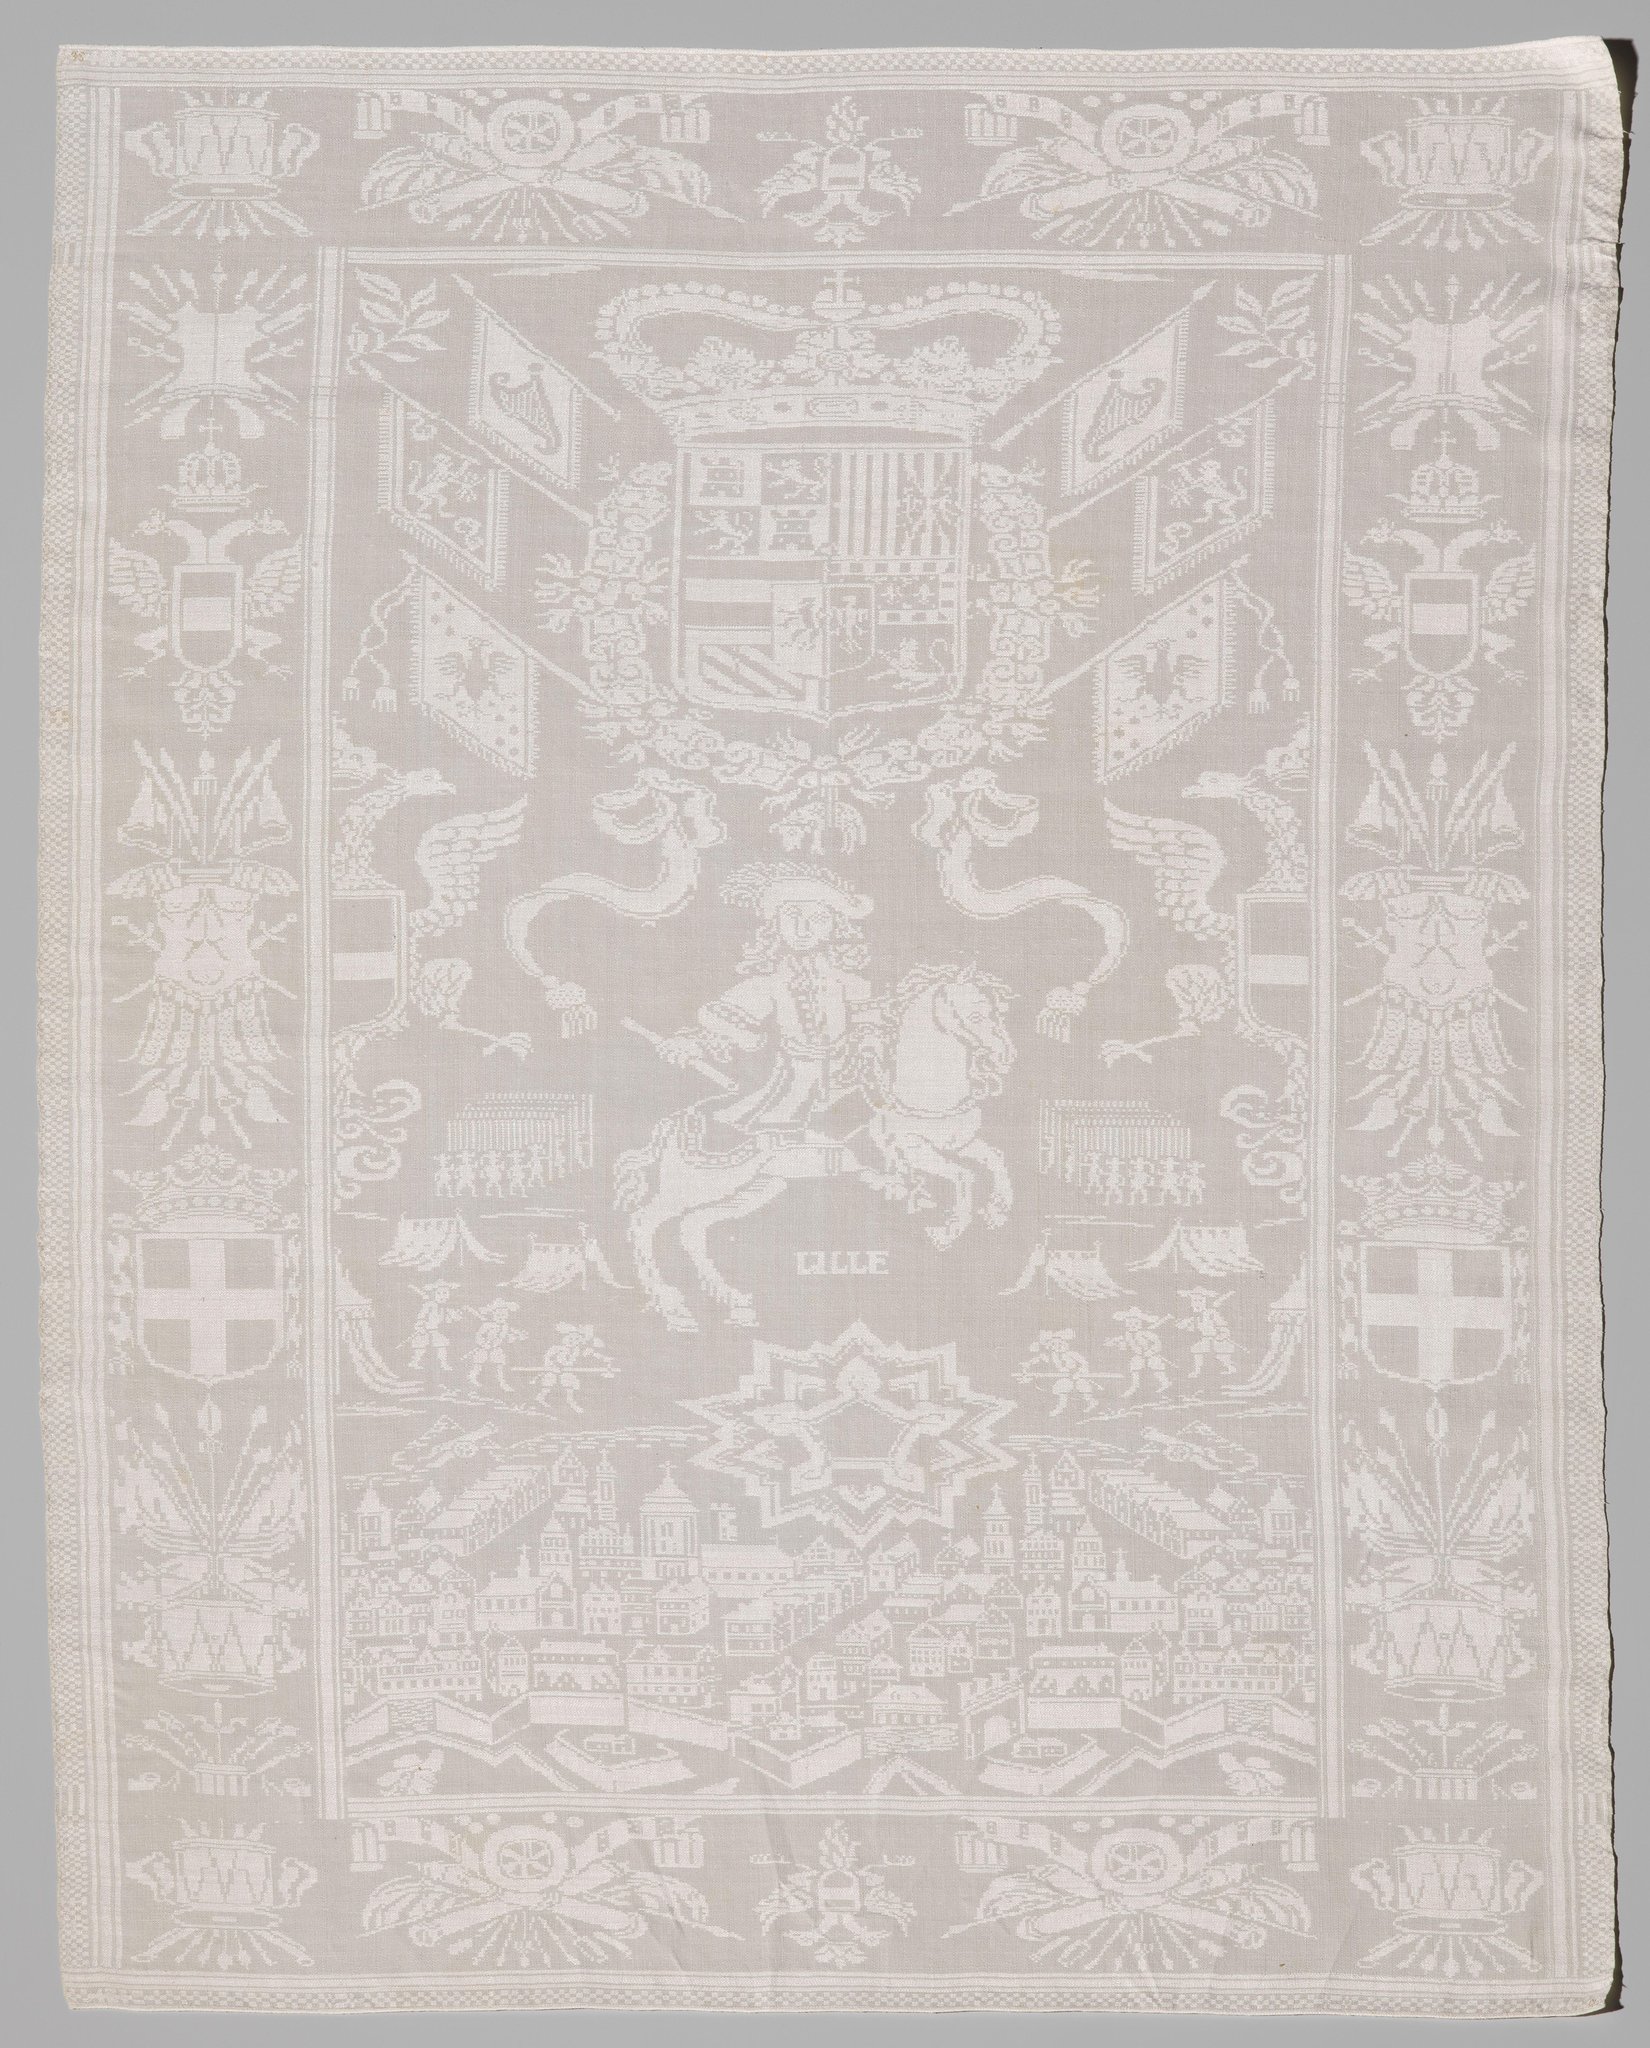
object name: napkin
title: Servet met het wapen van Karel III van Spanje en een gezicht op Rijssel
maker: Anonymous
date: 1702-1713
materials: linen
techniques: damask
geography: kortrijk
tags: charles vi (holy roman emperor), lille, spain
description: Servet van linnendamast met het wapen van Karel III van Spanje en een gezicht op Rijssel. Het symmetrisch patroon vertoont van onder naar boven de volgende taferelen: 1 Een gezicht op Rijssel met vele torens. 2 Plattegrond van een vesting met bovenschrift LILLE. 3 Ruiter te paard (Karel III van Spanje?). 4 Het wapen van Karel III van Spanje geflankeerd door vaandels. Staande en liggende randen: wapens, onder andere Savoye, en wapentrofeeën; daarbuiten: blokkenrand.